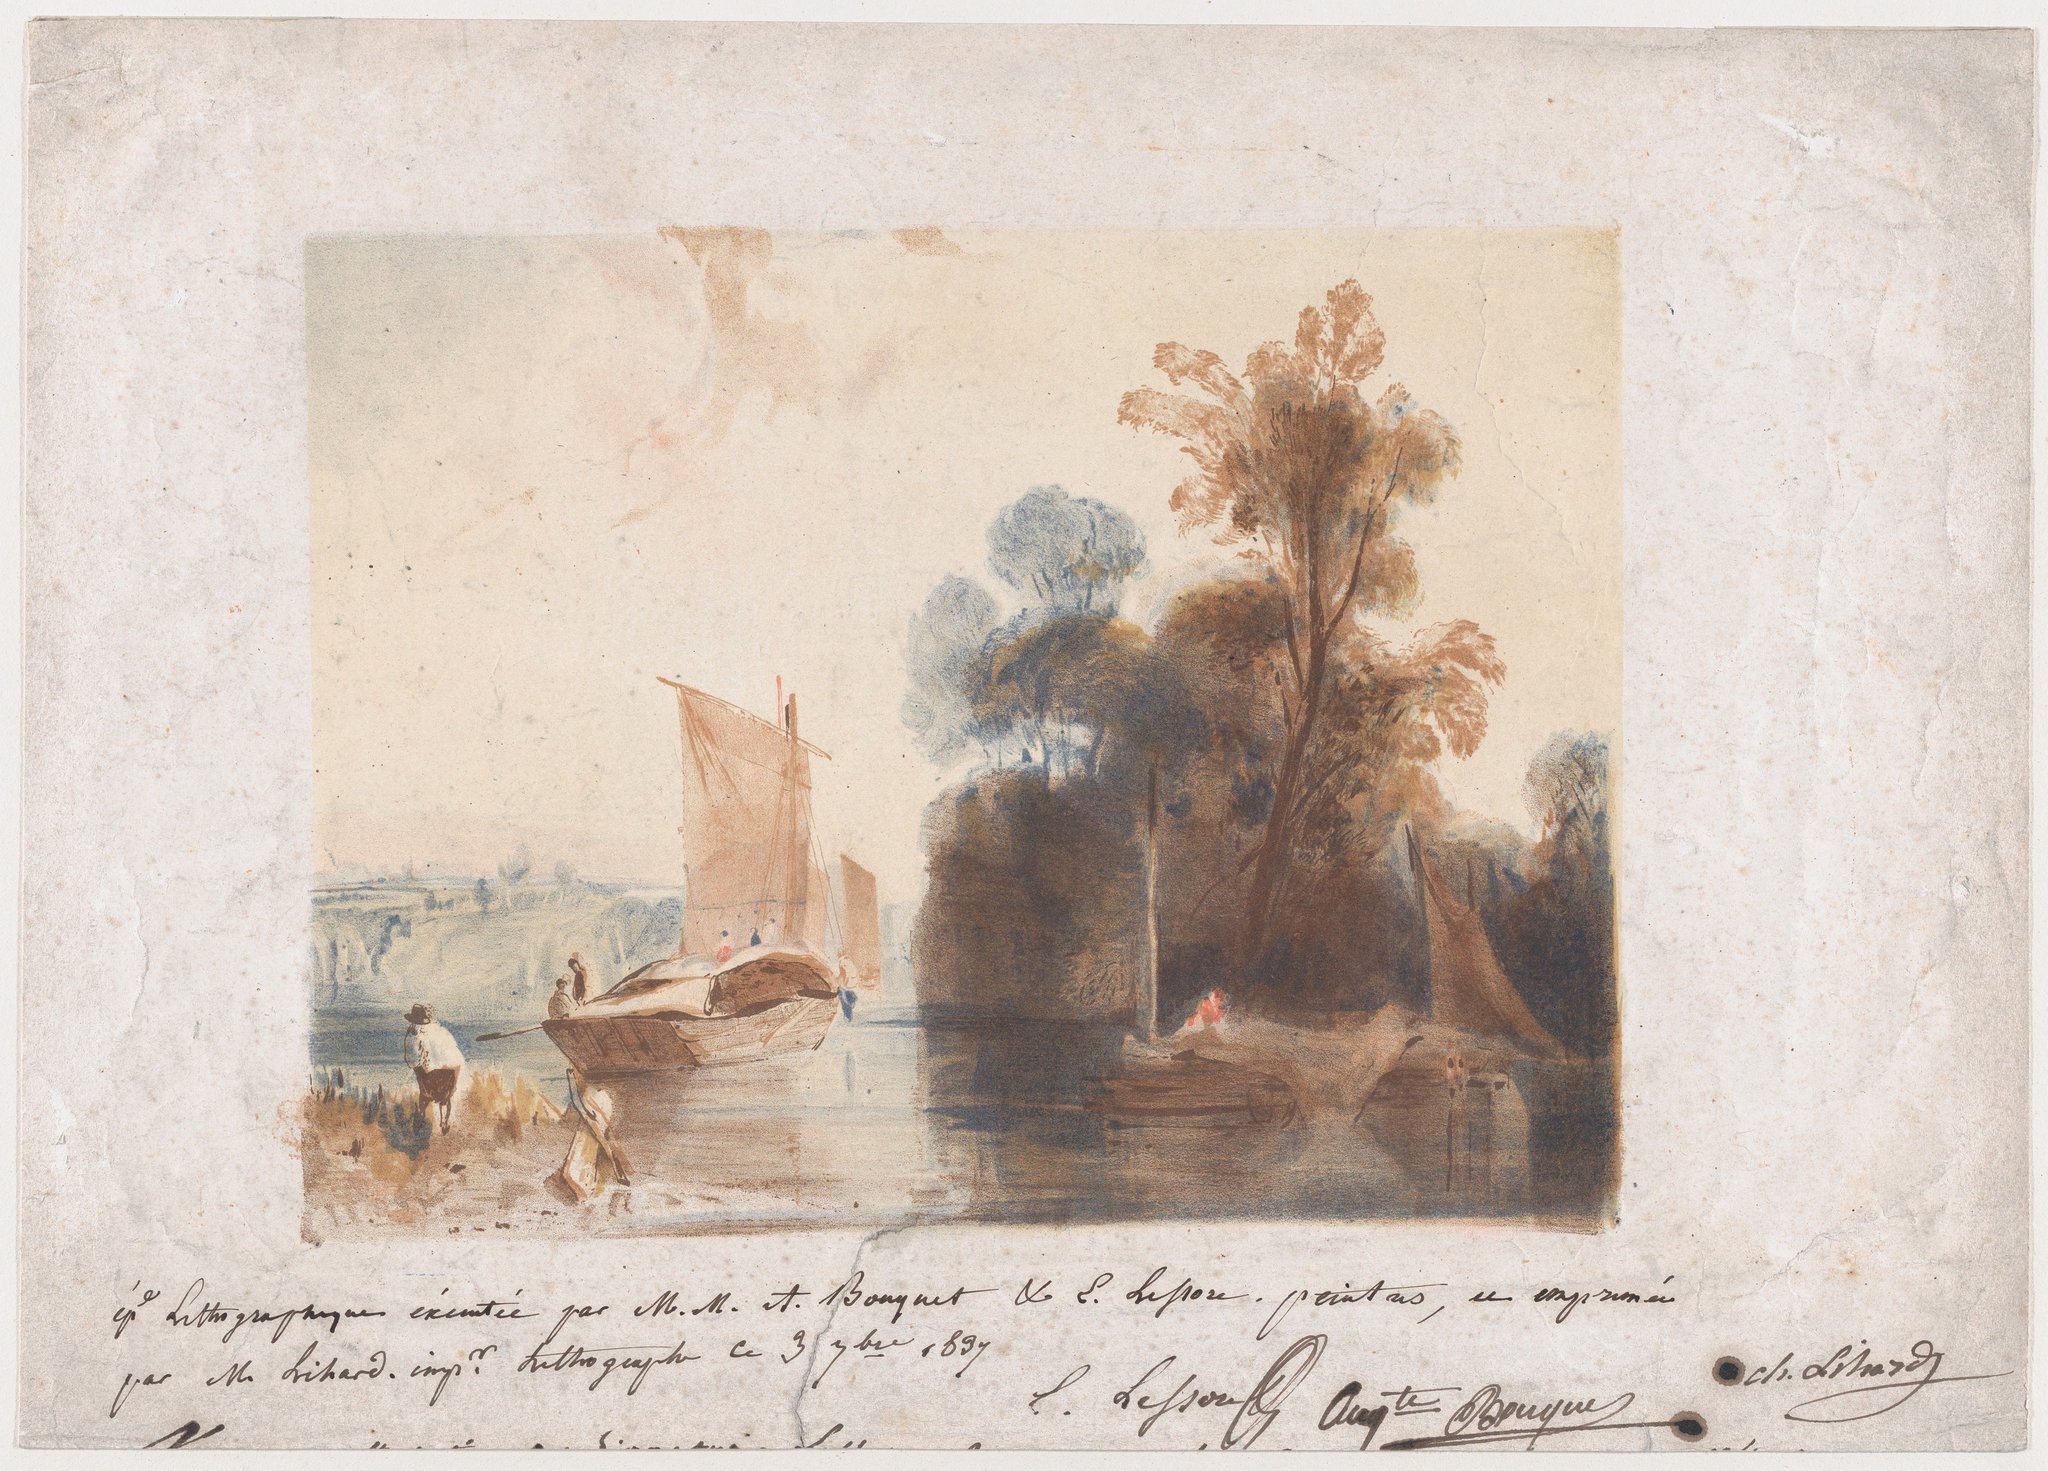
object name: print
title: Landscape with River and Boats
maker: auguste bouquet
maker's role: artist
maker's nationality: french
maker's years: 1810-1846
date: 1837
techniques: lithograph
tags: rivers,landscapes,boats